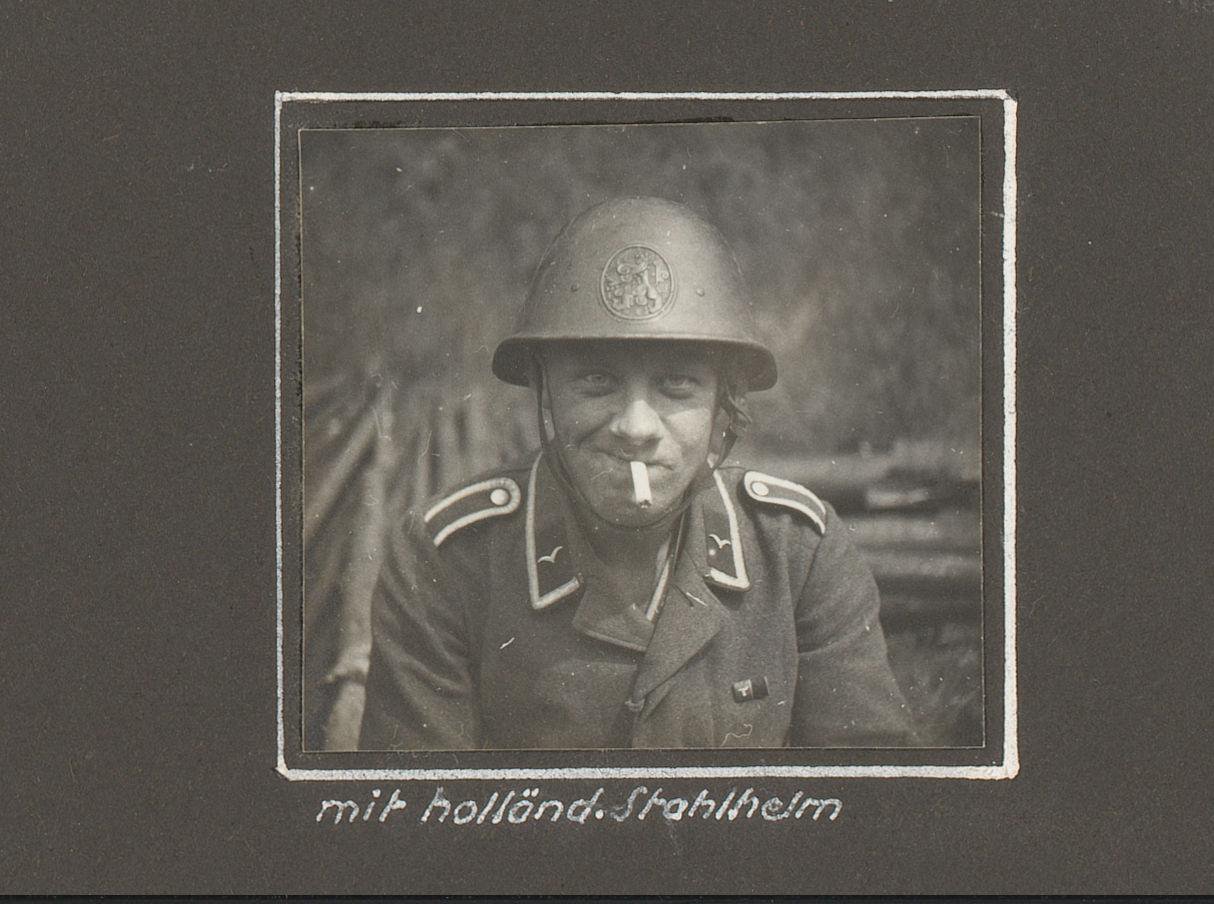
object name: photograph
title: mit holländ. Stahlhelm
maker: Anonymous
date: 1905-1940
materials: photographic support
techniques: gelatin silver print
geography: netherlands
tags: helmet, netherlands, germany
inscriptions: inscription: ‘mit holländ. Stahlhelm’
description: De samensteller van het album poseert met een veroverde Nederlandse helm op zijn kop. Foto op een albumblad in een Duits militair album Tweede Wereldoorlog 1939-1940.